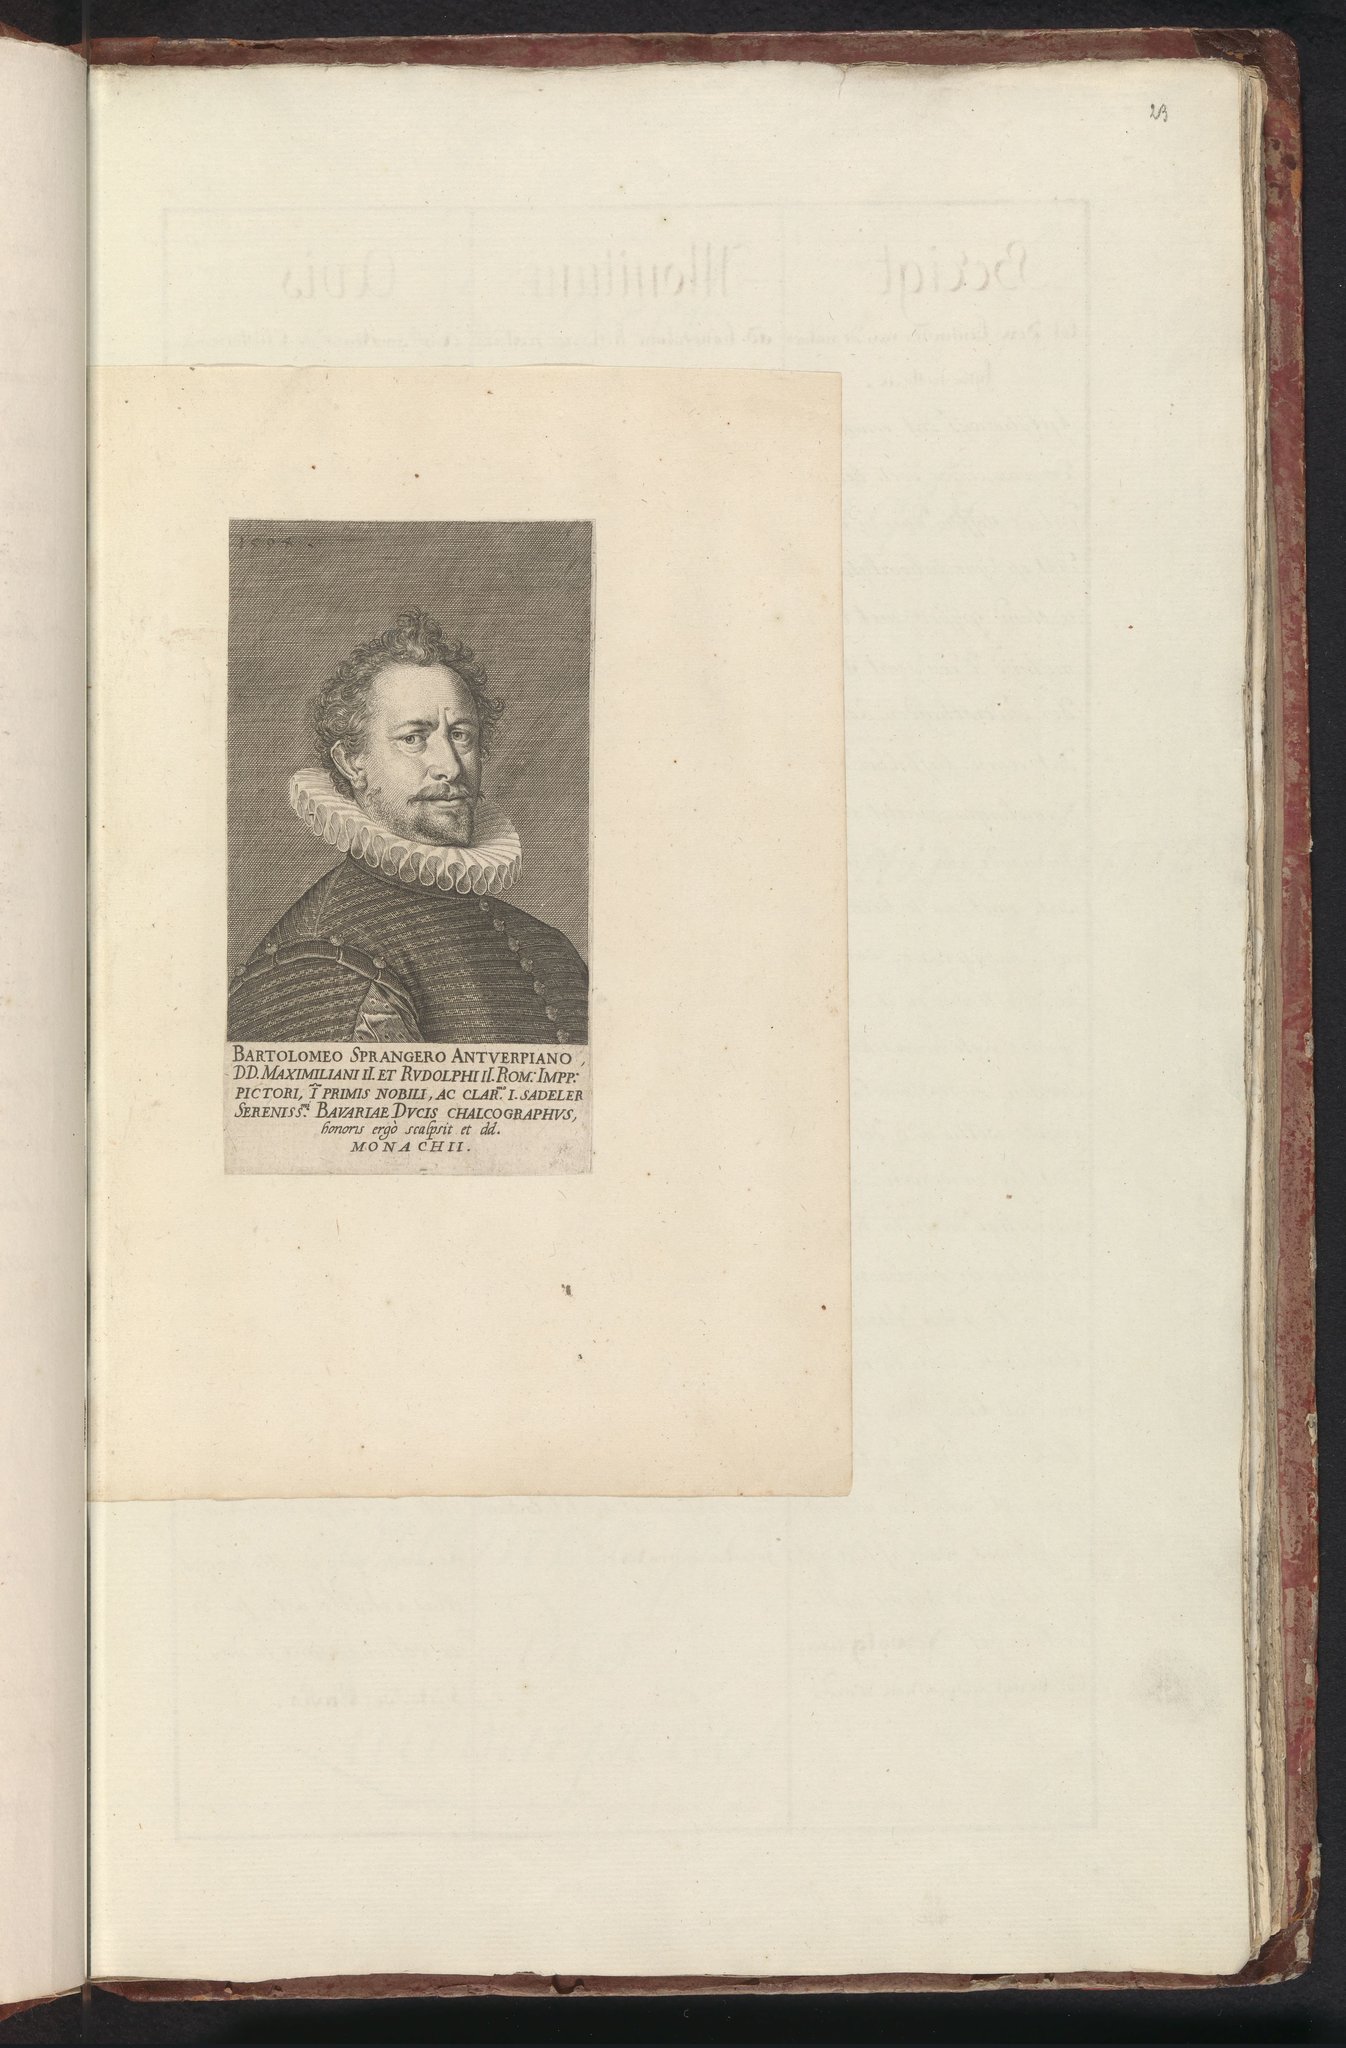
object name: print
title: Portret van Bartholomeus Spranger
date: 1594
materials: ink, paper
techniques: engraving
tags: antwerp, prague, painter, print maker, draughtsman, bartholomeus spranger, portrait, self-portrait of painter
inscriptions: date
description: De schilder Bartholomeus Spranger, gekleed in een wambuis met knopen, waarboven een brede geplooide kraag. Onderaan een Latijnse dedicatie aan Spranger in zes regels. Onderdeel van het eerste album met tekeningen van viervoeters. Eerste van twaalf albums met tekeningen van dieren, vogels en planten bekend rond 1600, gemaakt in opdracht van keizer Rudolf II. Met toelichting in Nederlands, Latijn en Frans.